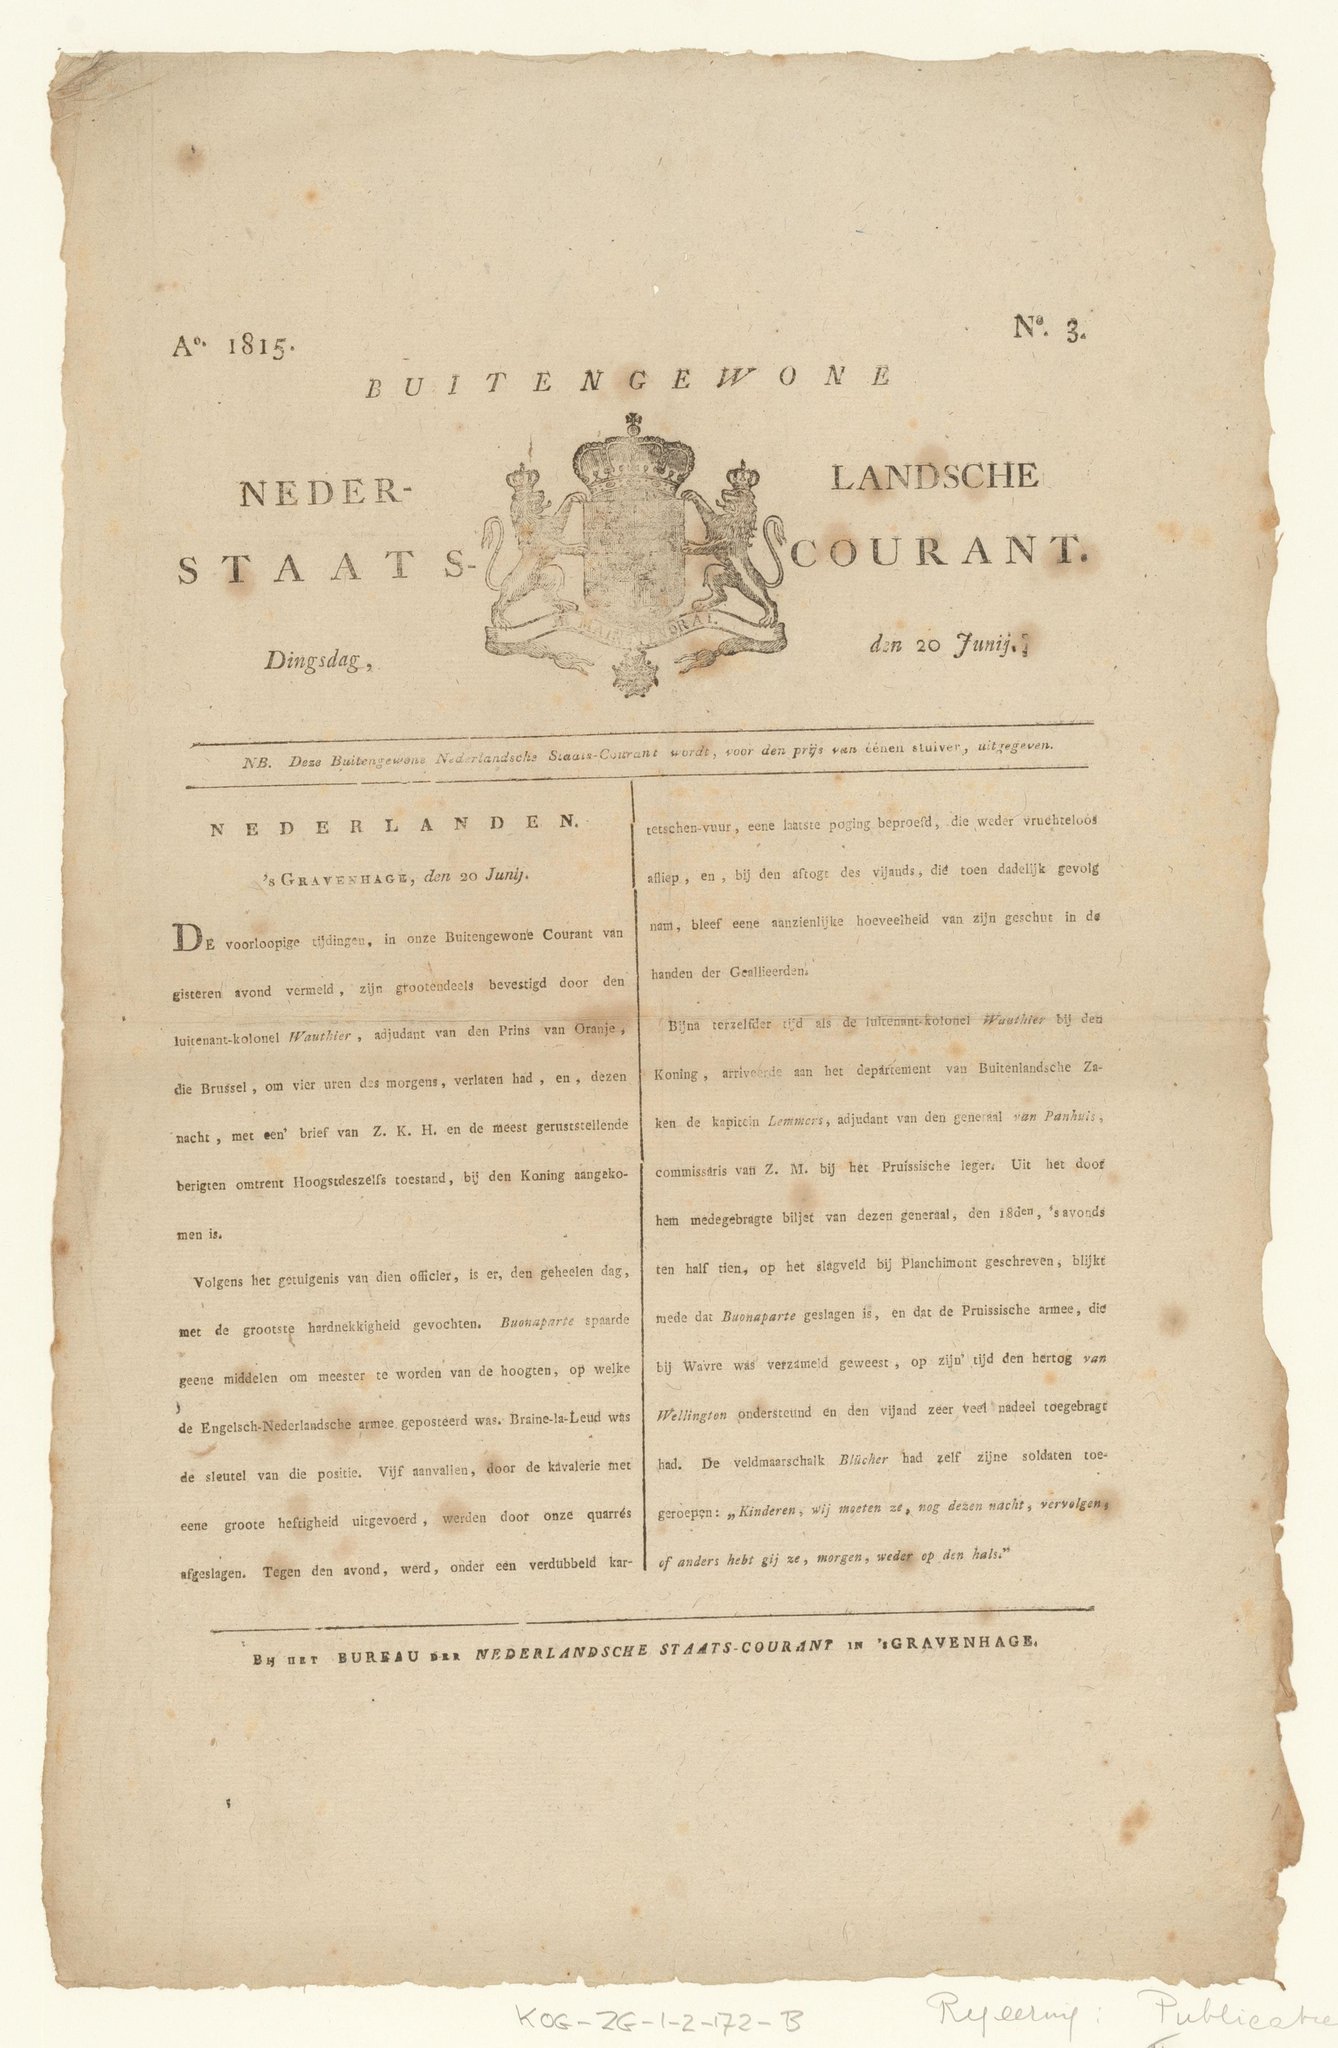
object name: newspaper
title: Buitengewone Nederlandsche Staatscourant, 20 juni 1815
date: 1815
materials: paper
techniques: letterpress printing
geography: the hague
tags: national government, newspaper, news-sheet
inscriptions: collector's mark: Lugt 1641, collector's mark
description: Exemplaar van de krant 'Buitengewone Nederlandsche Staatscourant' van 20 juni 1815 over de slag bij Waterloo. Gedrukte tekst met bovenaan het landswapen. Rechtsboven een stempel betaalde accijnzen. Onderwerpsrubrieken binnen de Atlas Zeden en Gewoonten: Regeering, Publicaties.